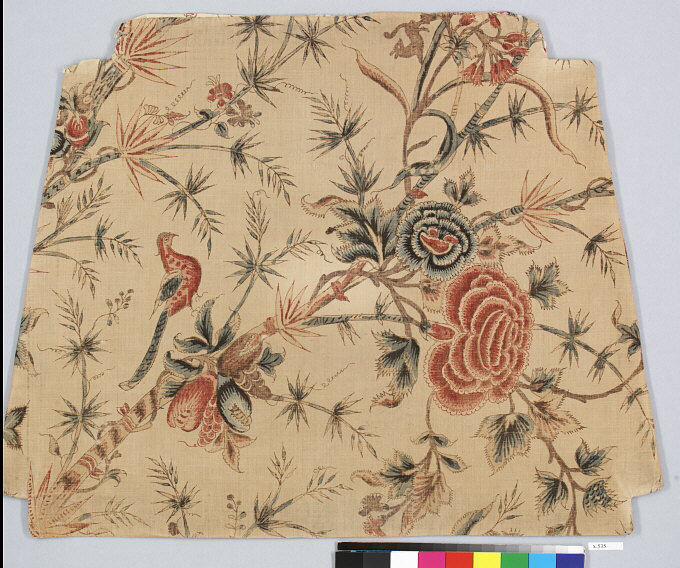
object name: upholstery panel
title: Chair seat cover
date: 1701-1800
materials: cotton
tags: birds,roses